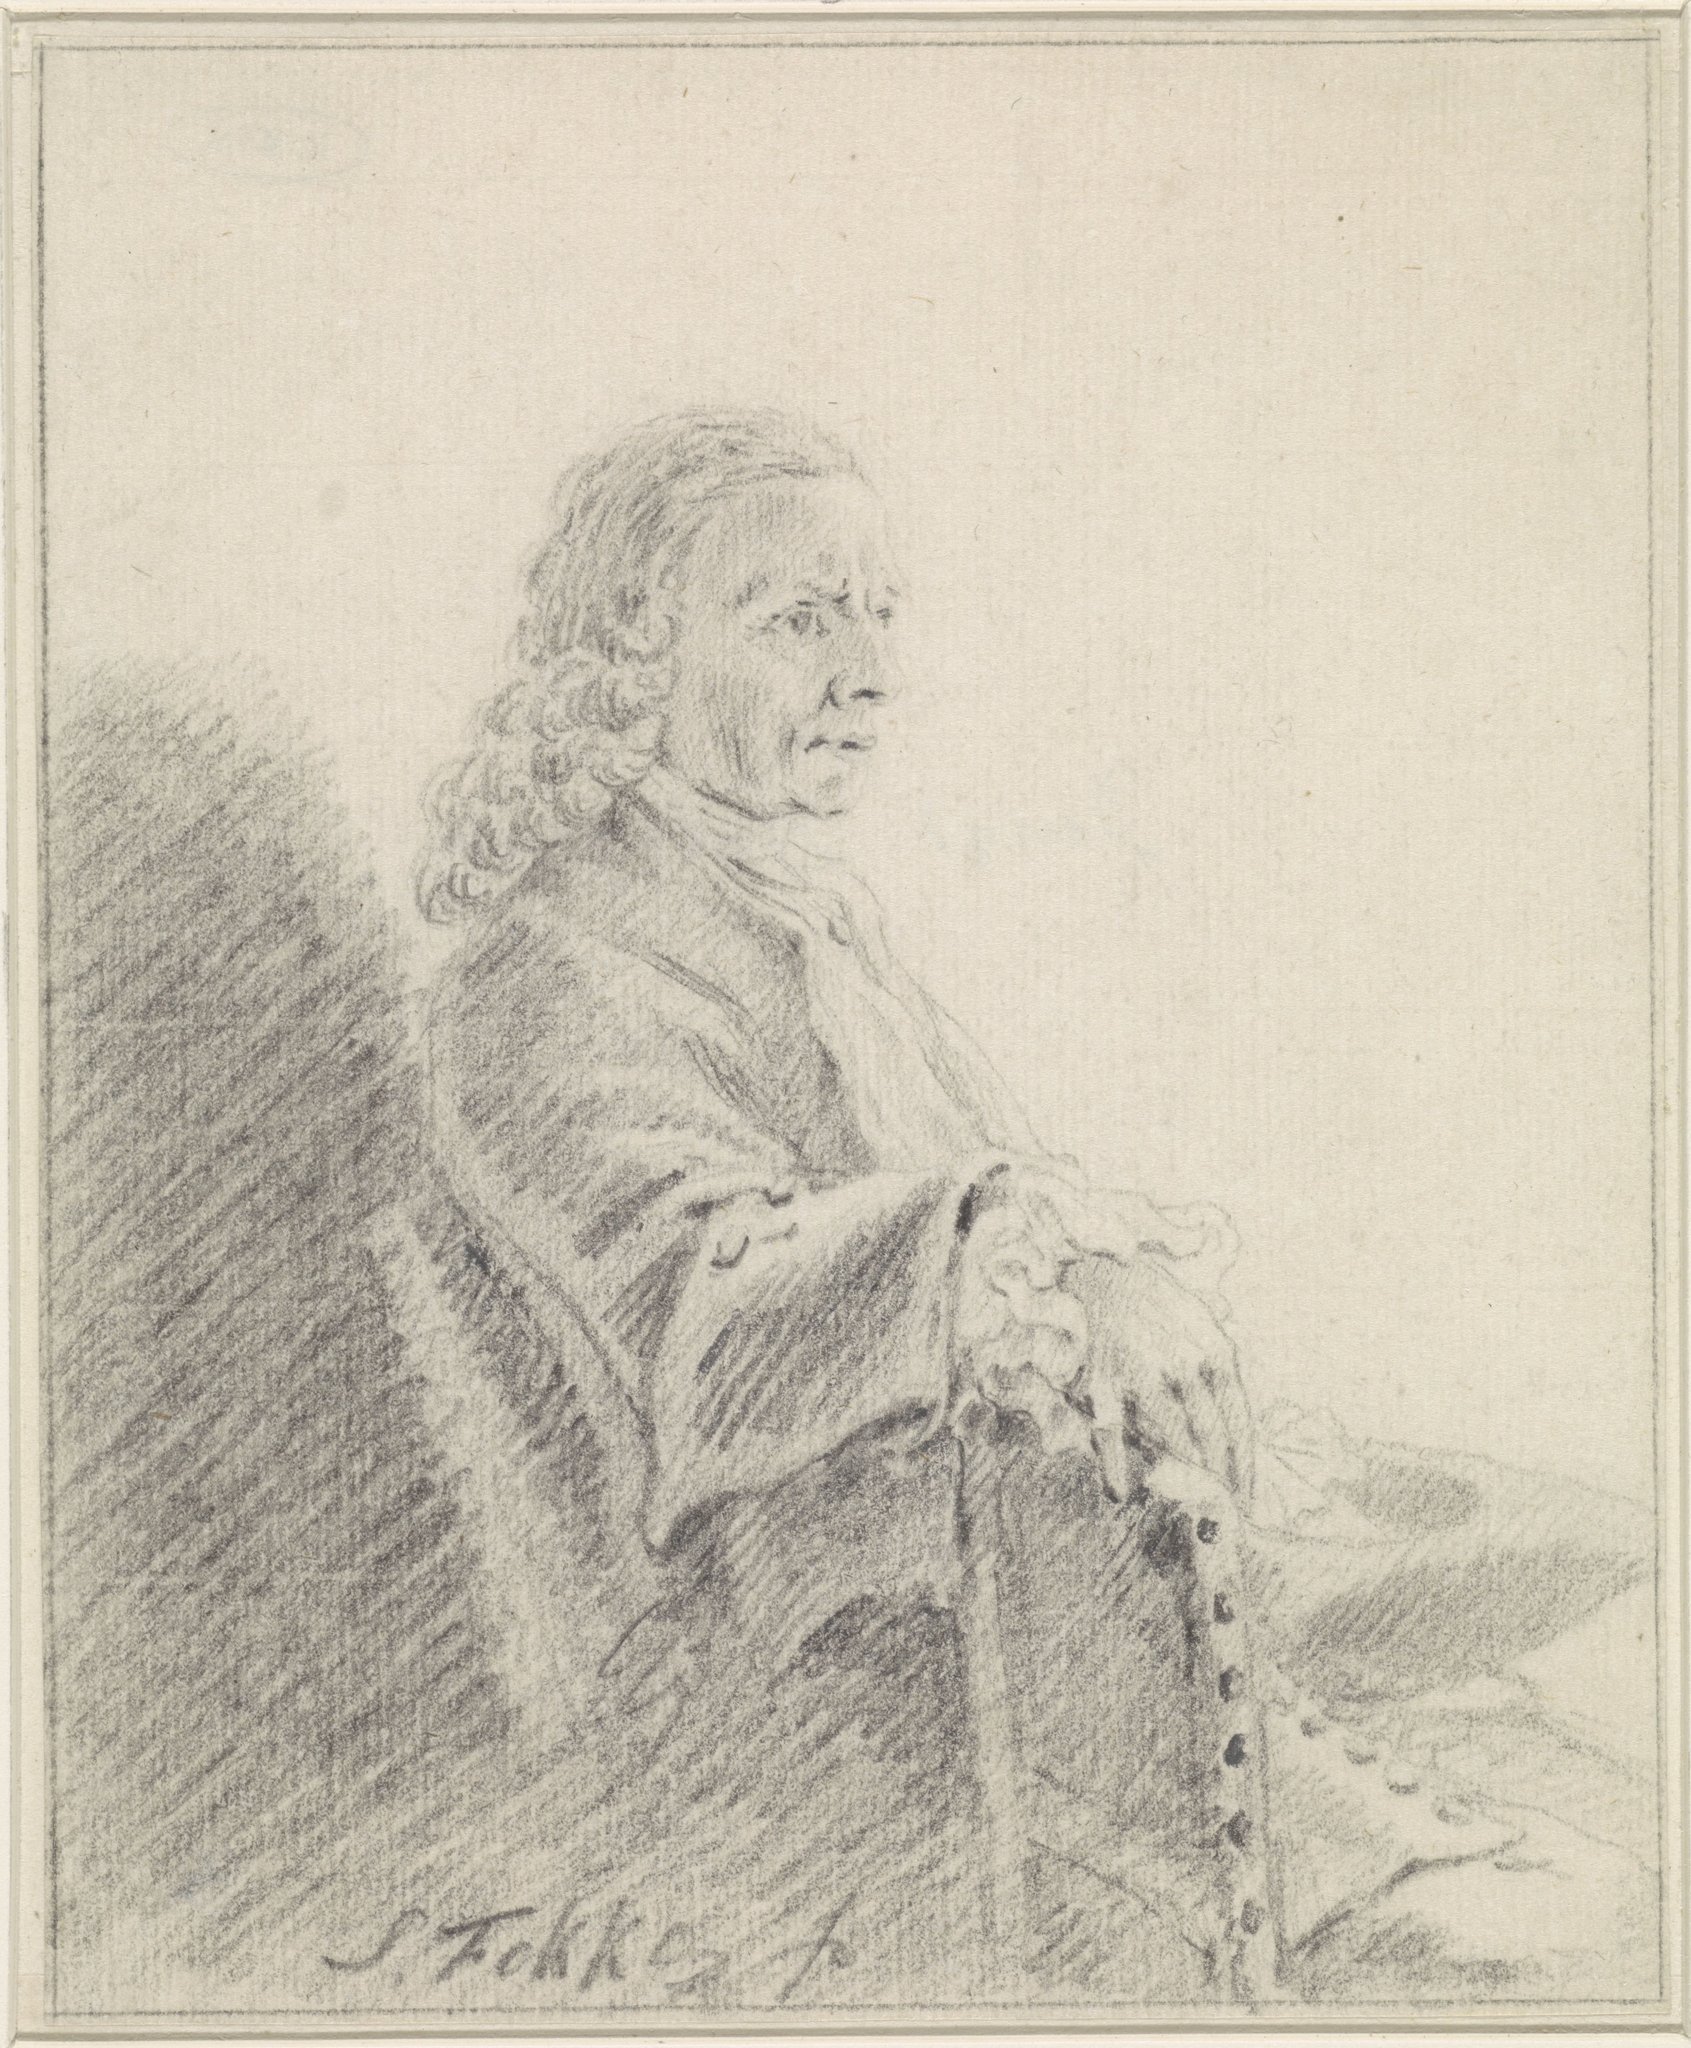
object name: drawing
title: Portret van Denys Dulignon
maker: simon fokke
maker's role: draughtsman, print maker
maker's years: 1712-1784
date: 1750-1784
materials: chalk, paper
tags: historical persons, portrait, self-portrait of painter, portrait, self-portrait of artist, portrait, self-portrait of draughtsman